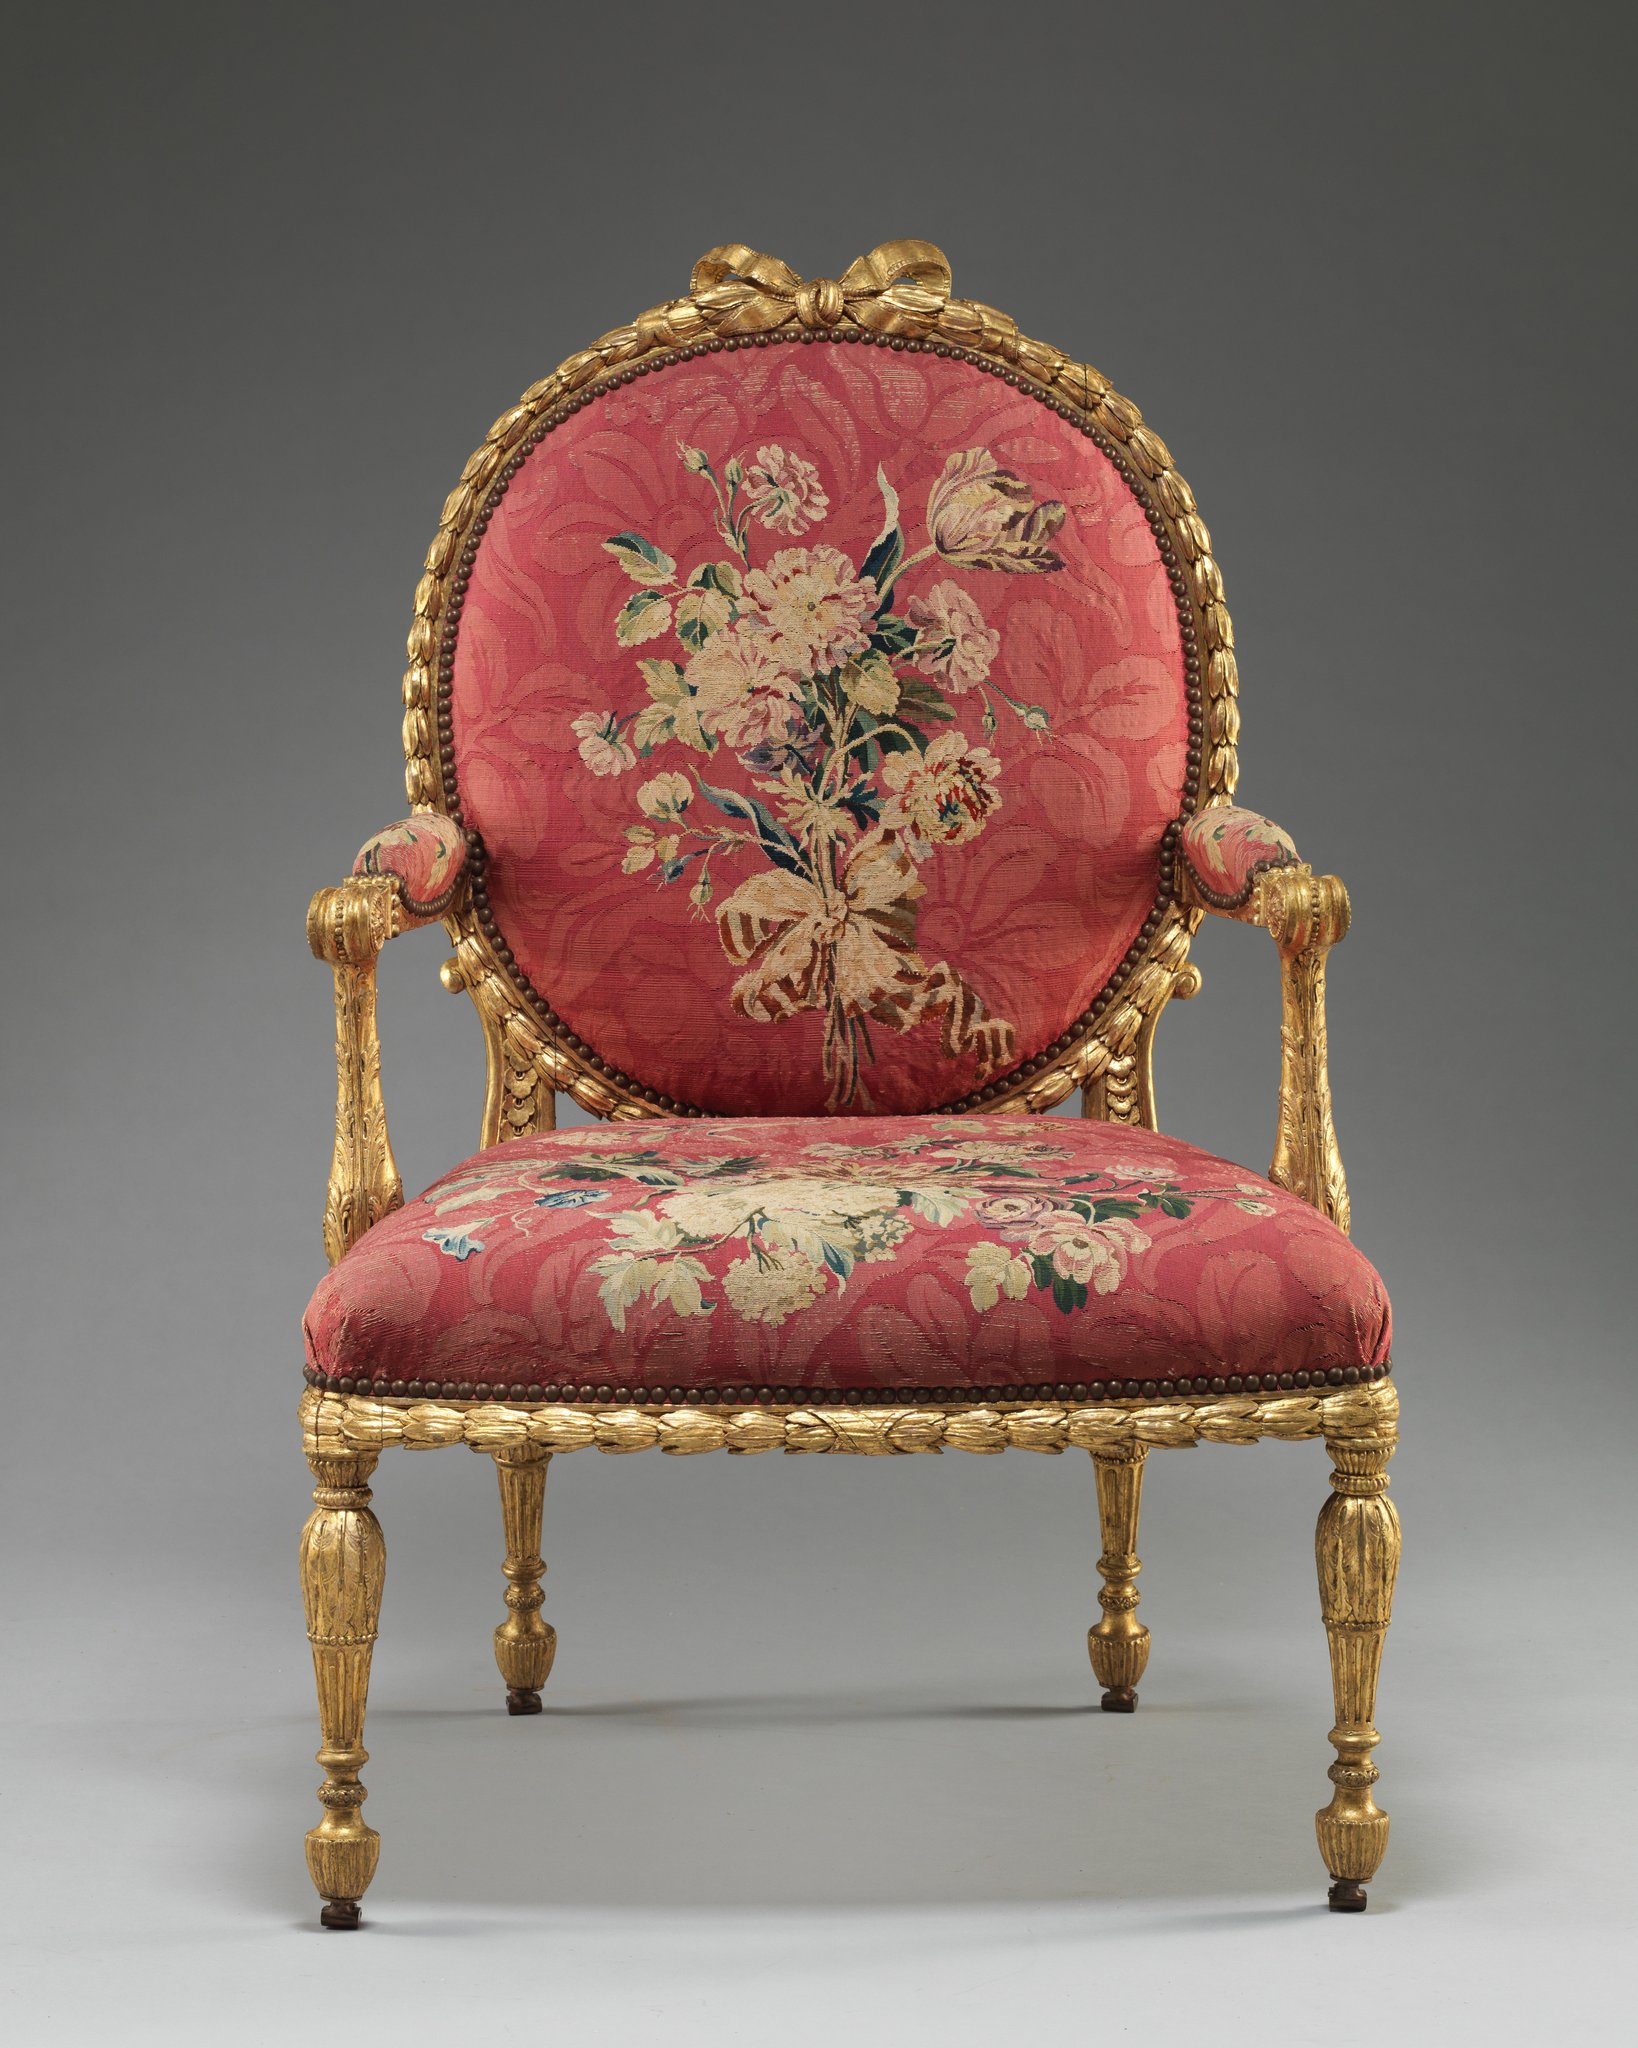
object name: armchair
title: Armchair (one of a set of six)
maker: john mayhew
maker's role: maker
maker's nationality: british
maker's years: 1736-1811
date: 1769-1771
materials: wood, silk, wool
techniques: gilding